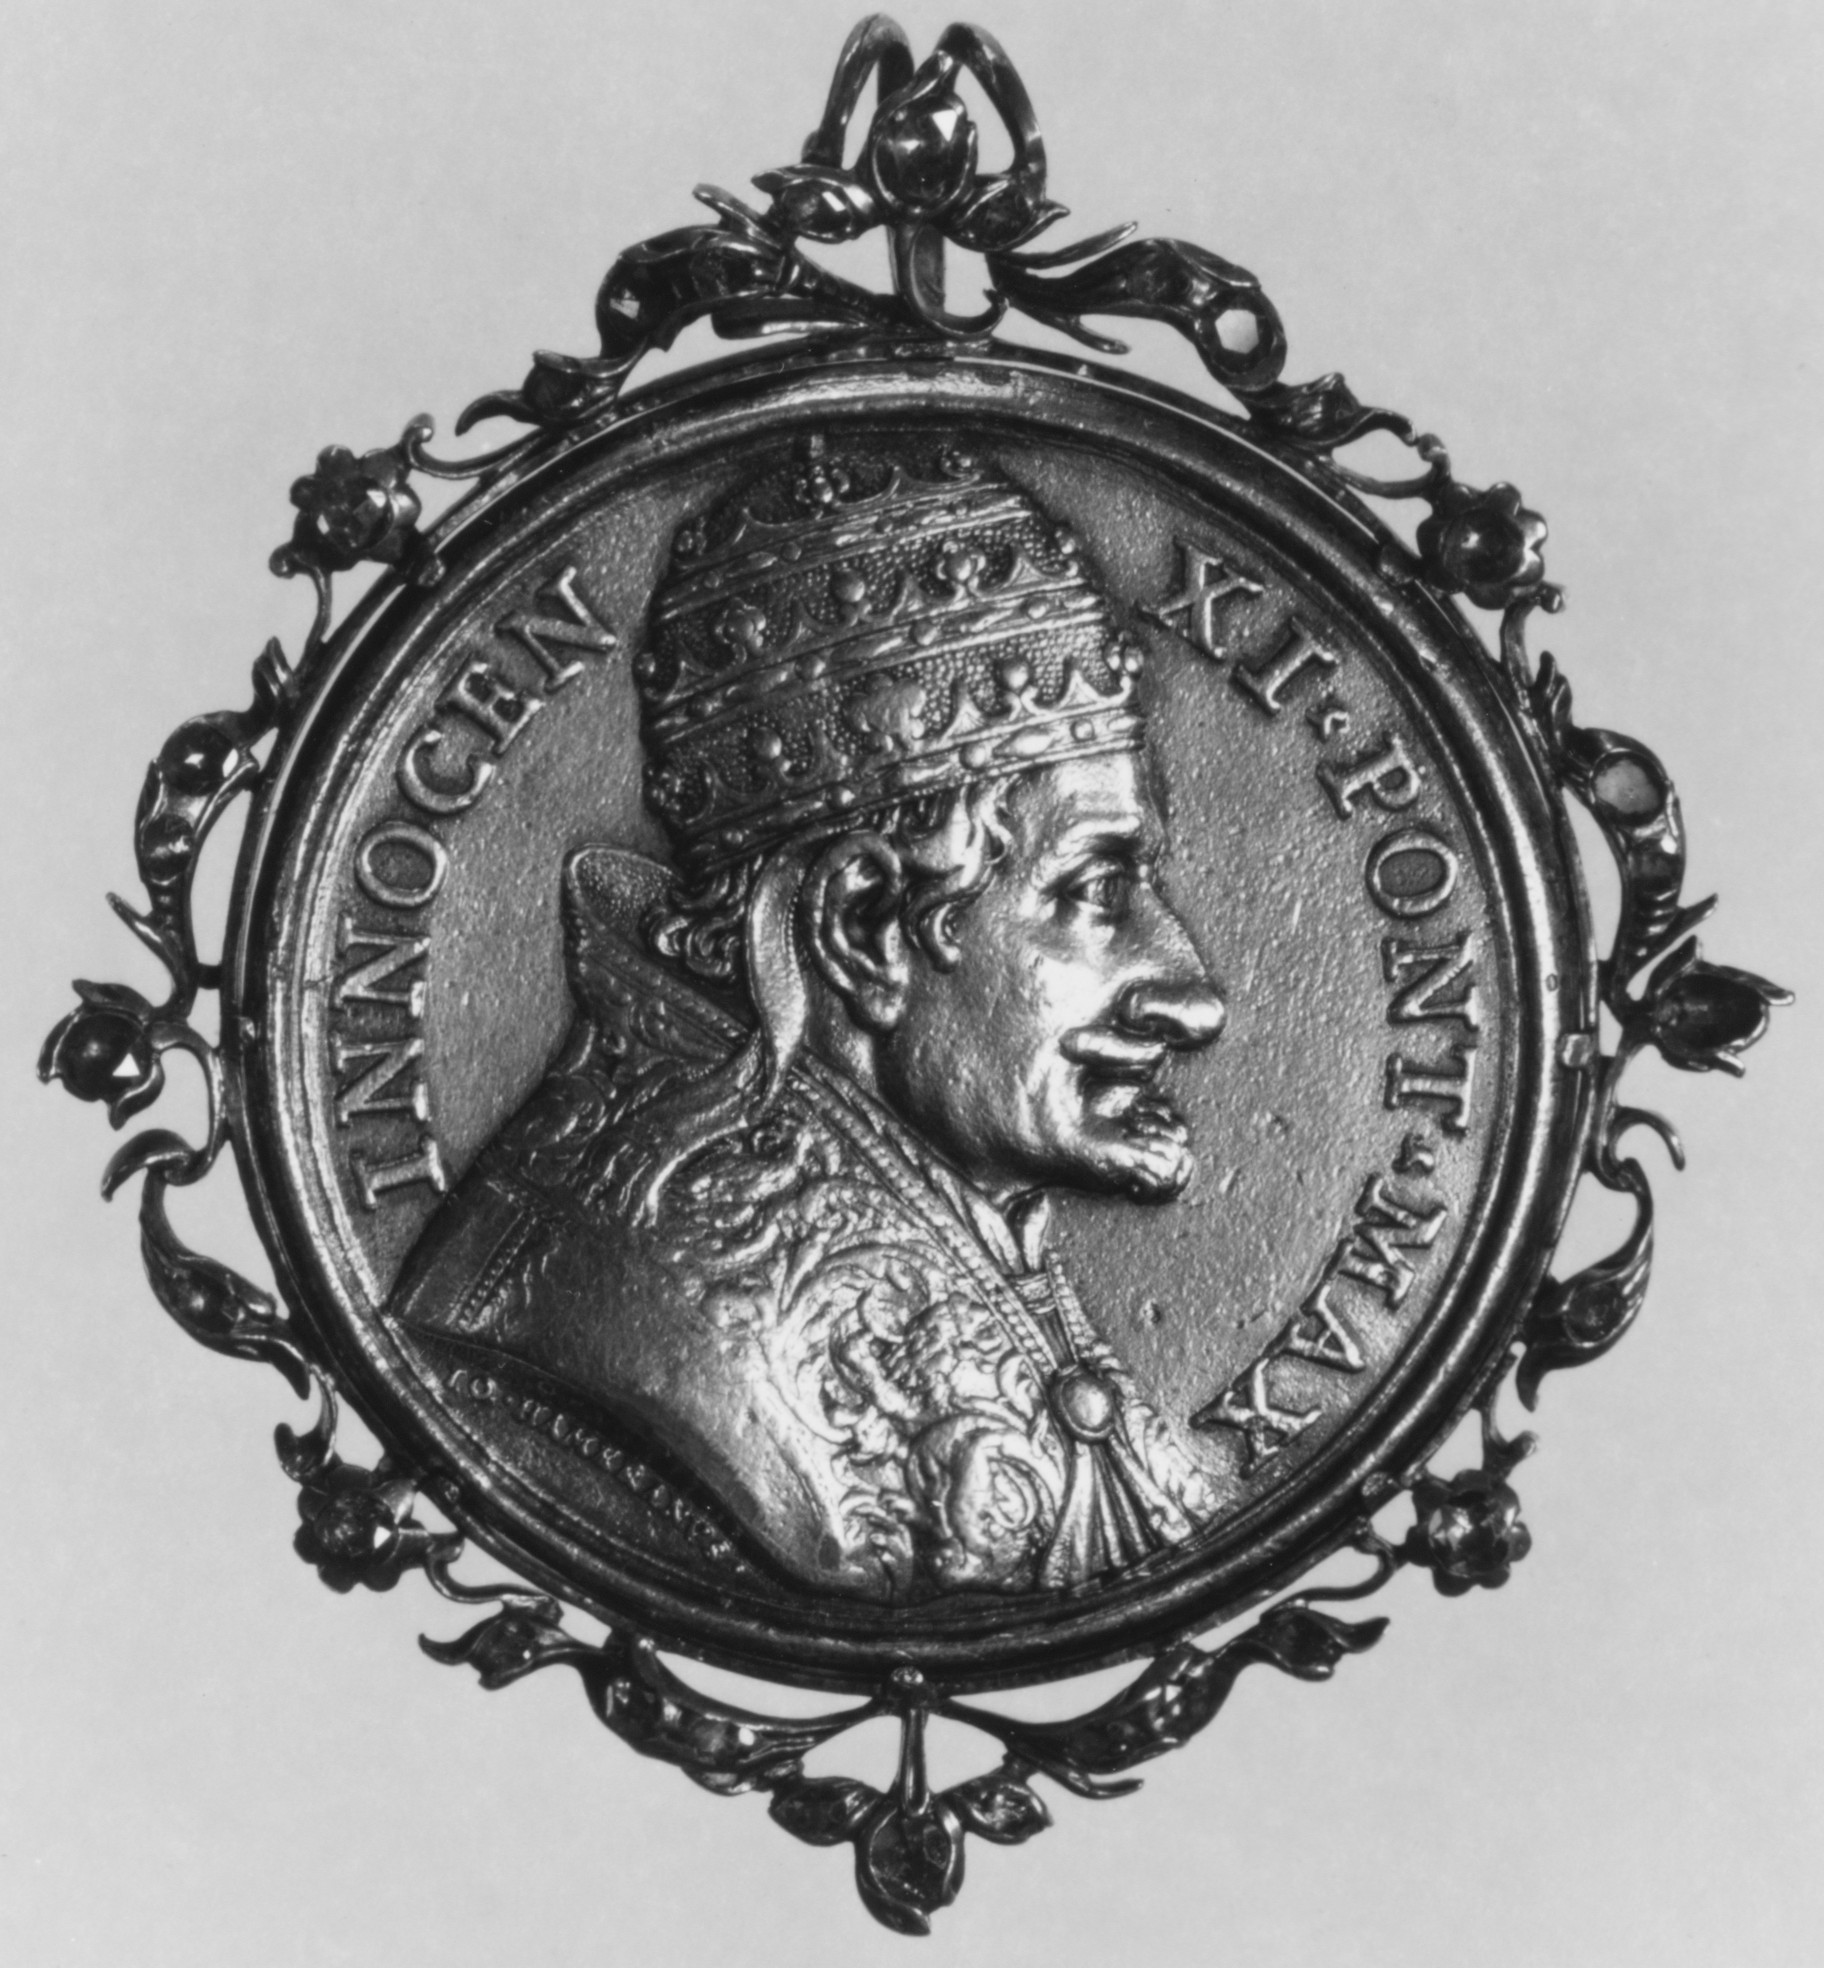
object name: medal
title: Pope Innocent XI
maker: giovanni martino hamerani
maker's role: artist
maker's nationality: italian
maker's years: 1646-1705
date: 1679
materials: silver gilt, stone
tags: men,profiles,angels,popes